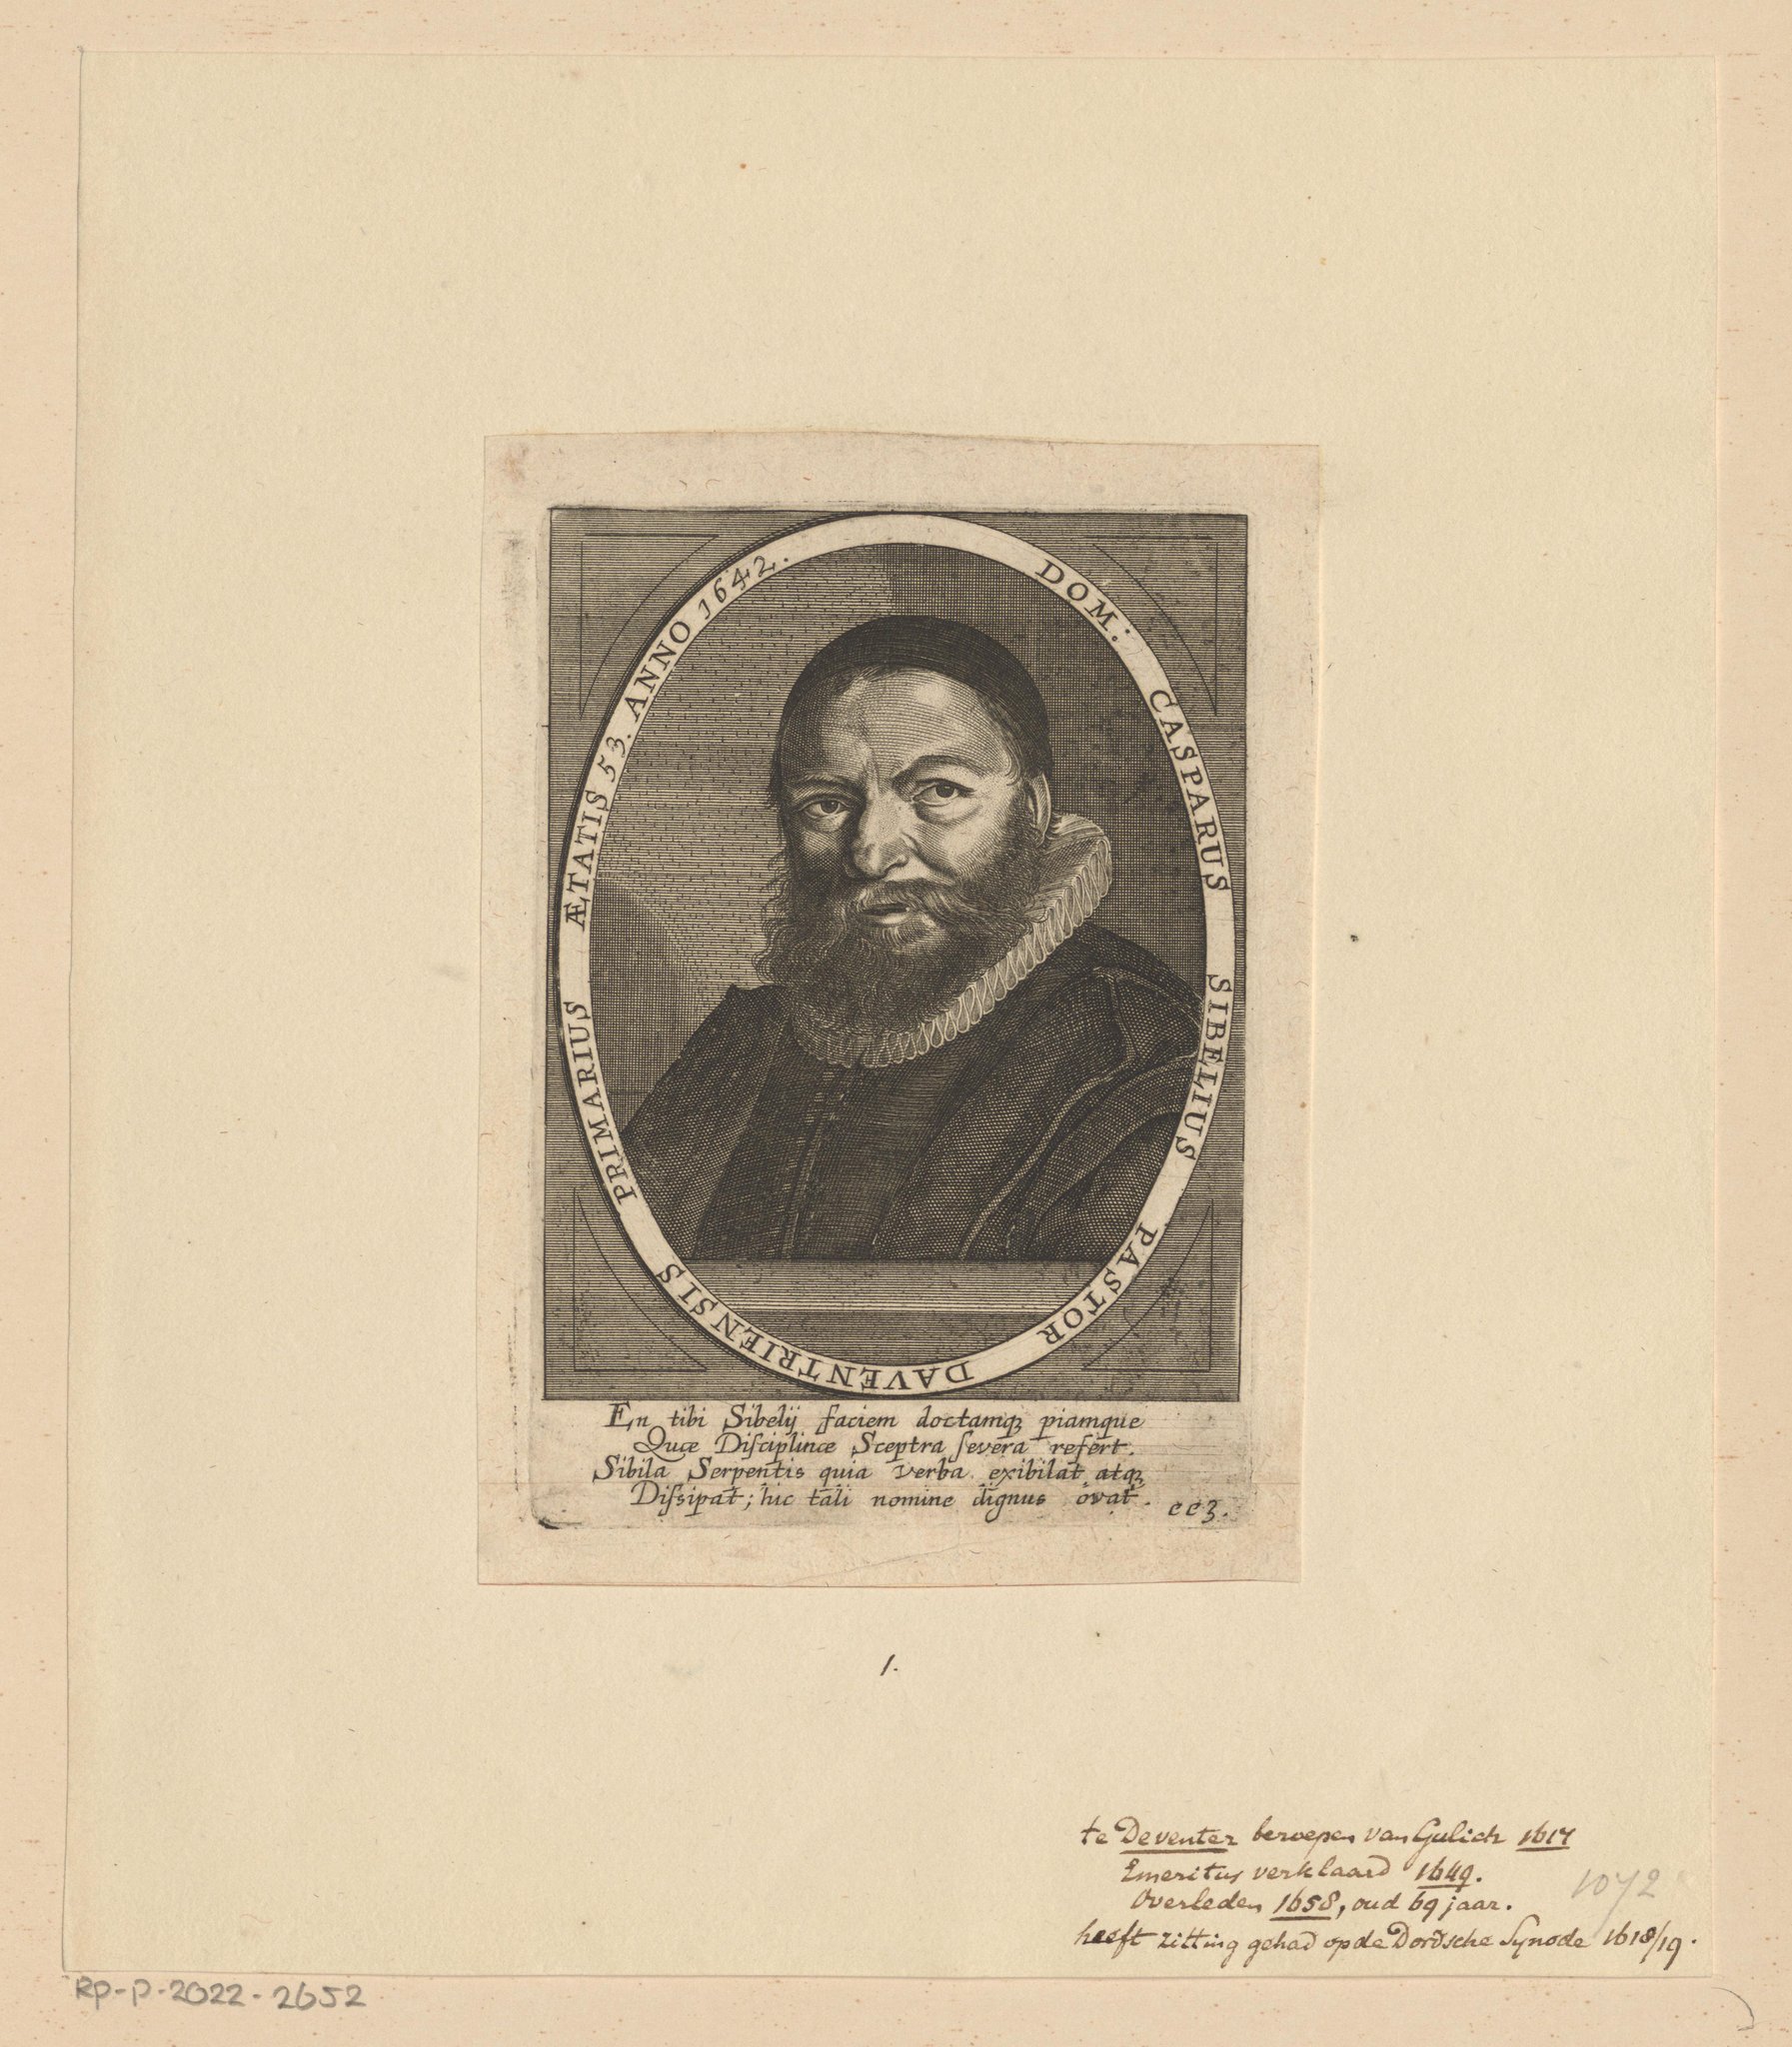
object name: print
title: Portretten van geleerden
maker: Anonymous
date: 1650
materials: paper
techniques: engraving, snipping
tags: theologian, historical persons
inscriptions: number: ‘1’, inscription: ‘te Deventer beroepen (...) Dordsche Synode 1618/19.’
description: Prent uit: Boissard, Jean Jacques. Bibliotheca chalcographica (...) VII pars. Frankfurt am Main: Johannes Ammon, 1650.